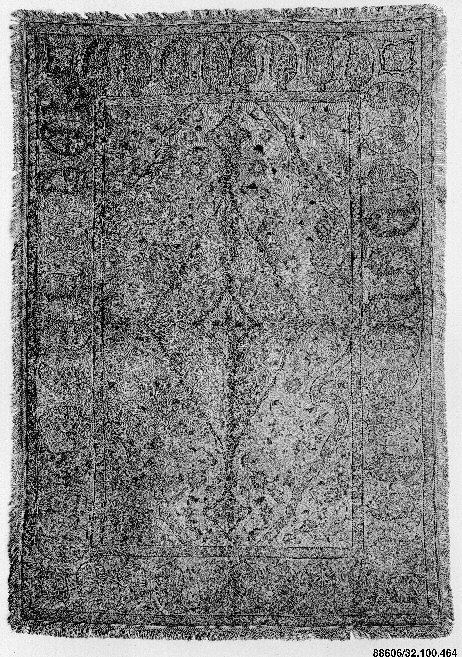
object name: hanging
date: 1601-1700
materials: linen, metal, silk, thread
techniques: embroidery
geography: iran